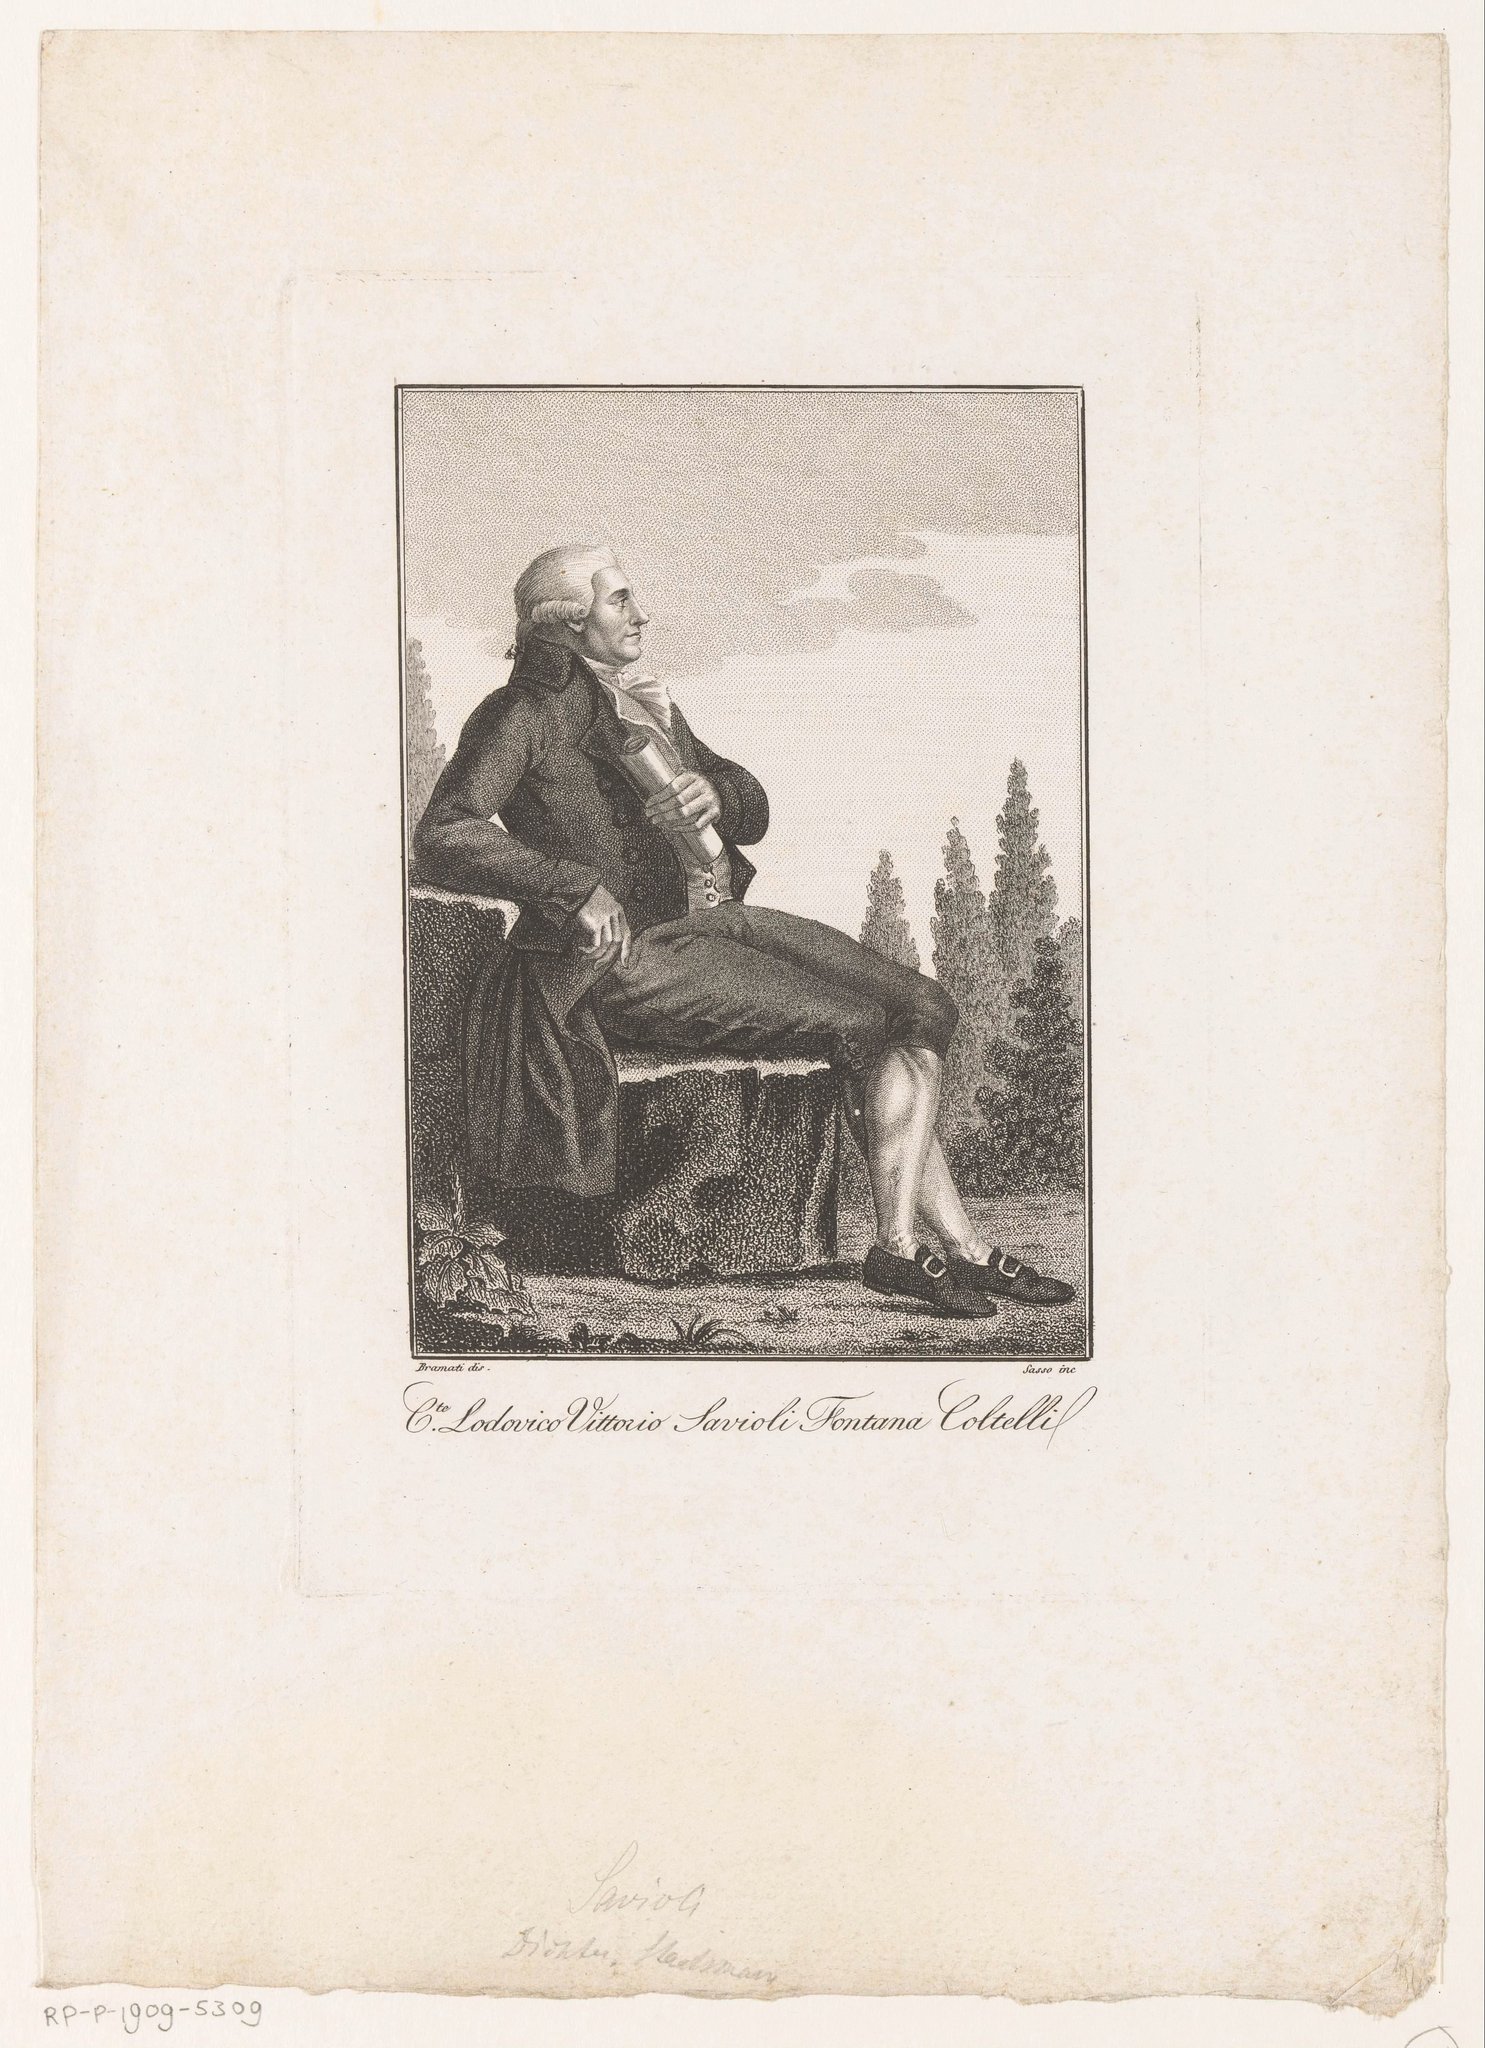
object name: print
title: Portret van dichter en historicus Ludovico Savioli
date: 1809-1816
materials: paper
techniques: engraving, etching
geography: italy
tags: historical persons, writer, poet, author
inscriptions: collector's mark: Lugt 2228